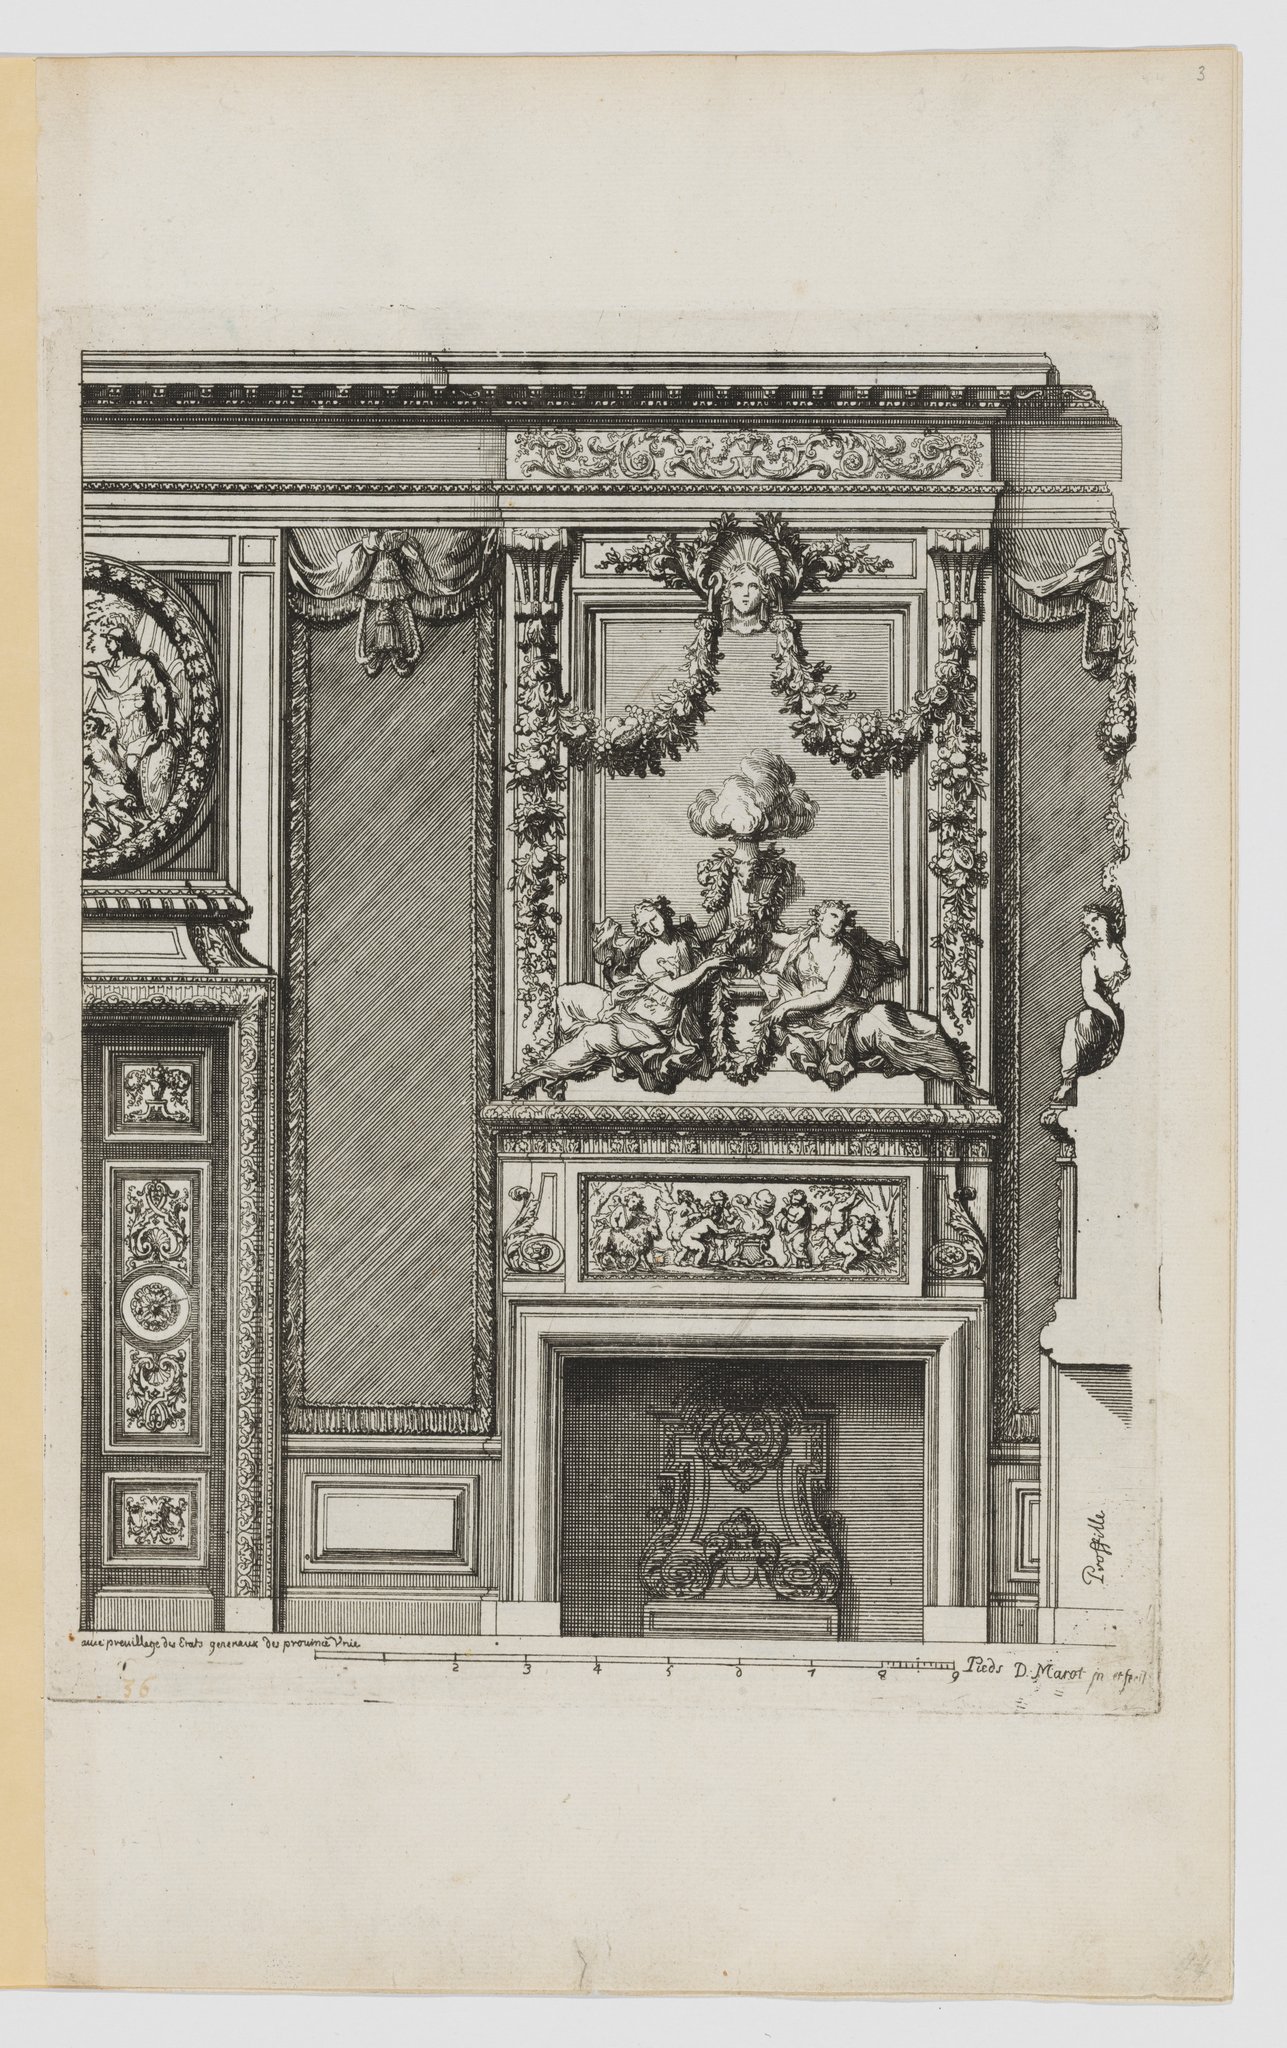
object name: print collection ornament architecture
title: Chimney-Piece with Nymphs Flanking an Smoking Urn on the Overmantel, from Nouvelles Cheminées Faittes en Plusieur en Droits de la Hollande et Autres Prouinces, part of Œuvres du Sr. D. Marot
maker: daniel marot the elder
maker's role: artist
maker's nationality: french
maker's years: 1661-1752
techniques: etching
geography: netherlands